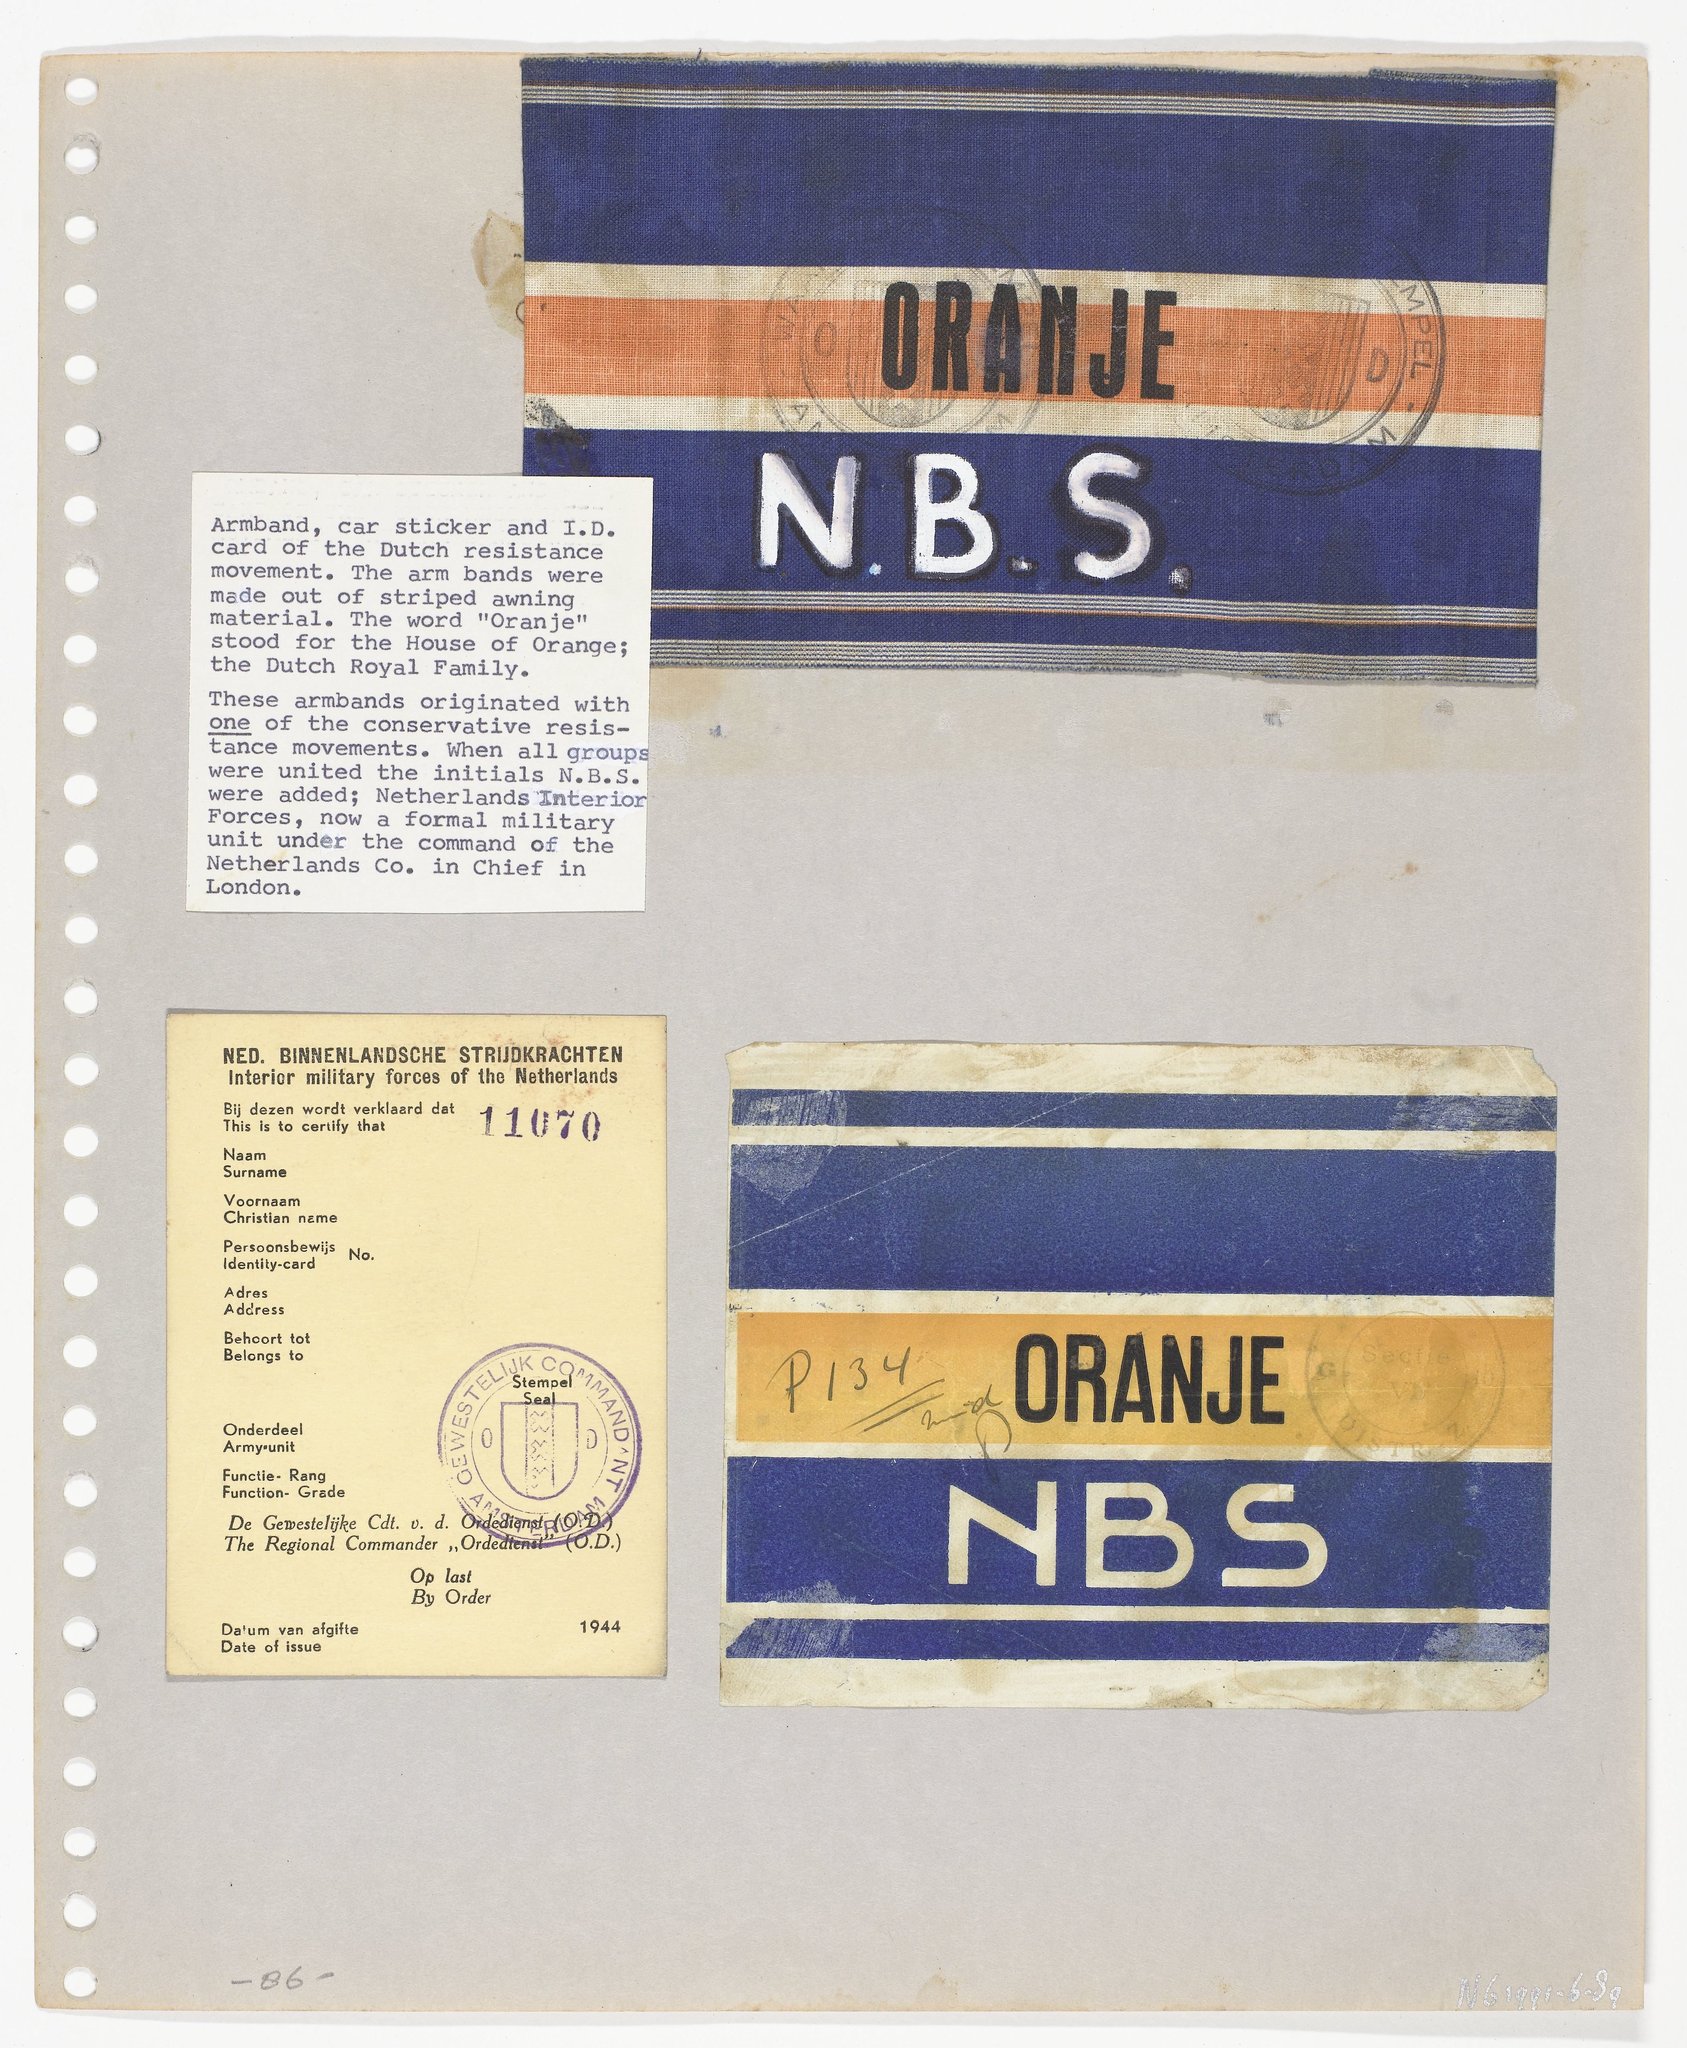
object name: album leaf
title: Mouwband van de NBS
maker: Anonymous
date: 1905-1945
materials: paper, plastic, textile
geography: netherlands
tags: amsterdam, tonny van renterghem, berlin, fritz kahlenberg, underground movement, partisans, netherlands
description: Mouwband van de Nederlandse Binnenlandse Strijdkrachten (NBS) met boven NBS het woord Oranje. De kleuren zijn blauw, wit en oranje. Hierbij ook een exemplaar van papier voor op een auto. Rechts hiervan een ID van de NBS, zonder naam, met stempel van Gewestelijk Commandant Amsterdam.